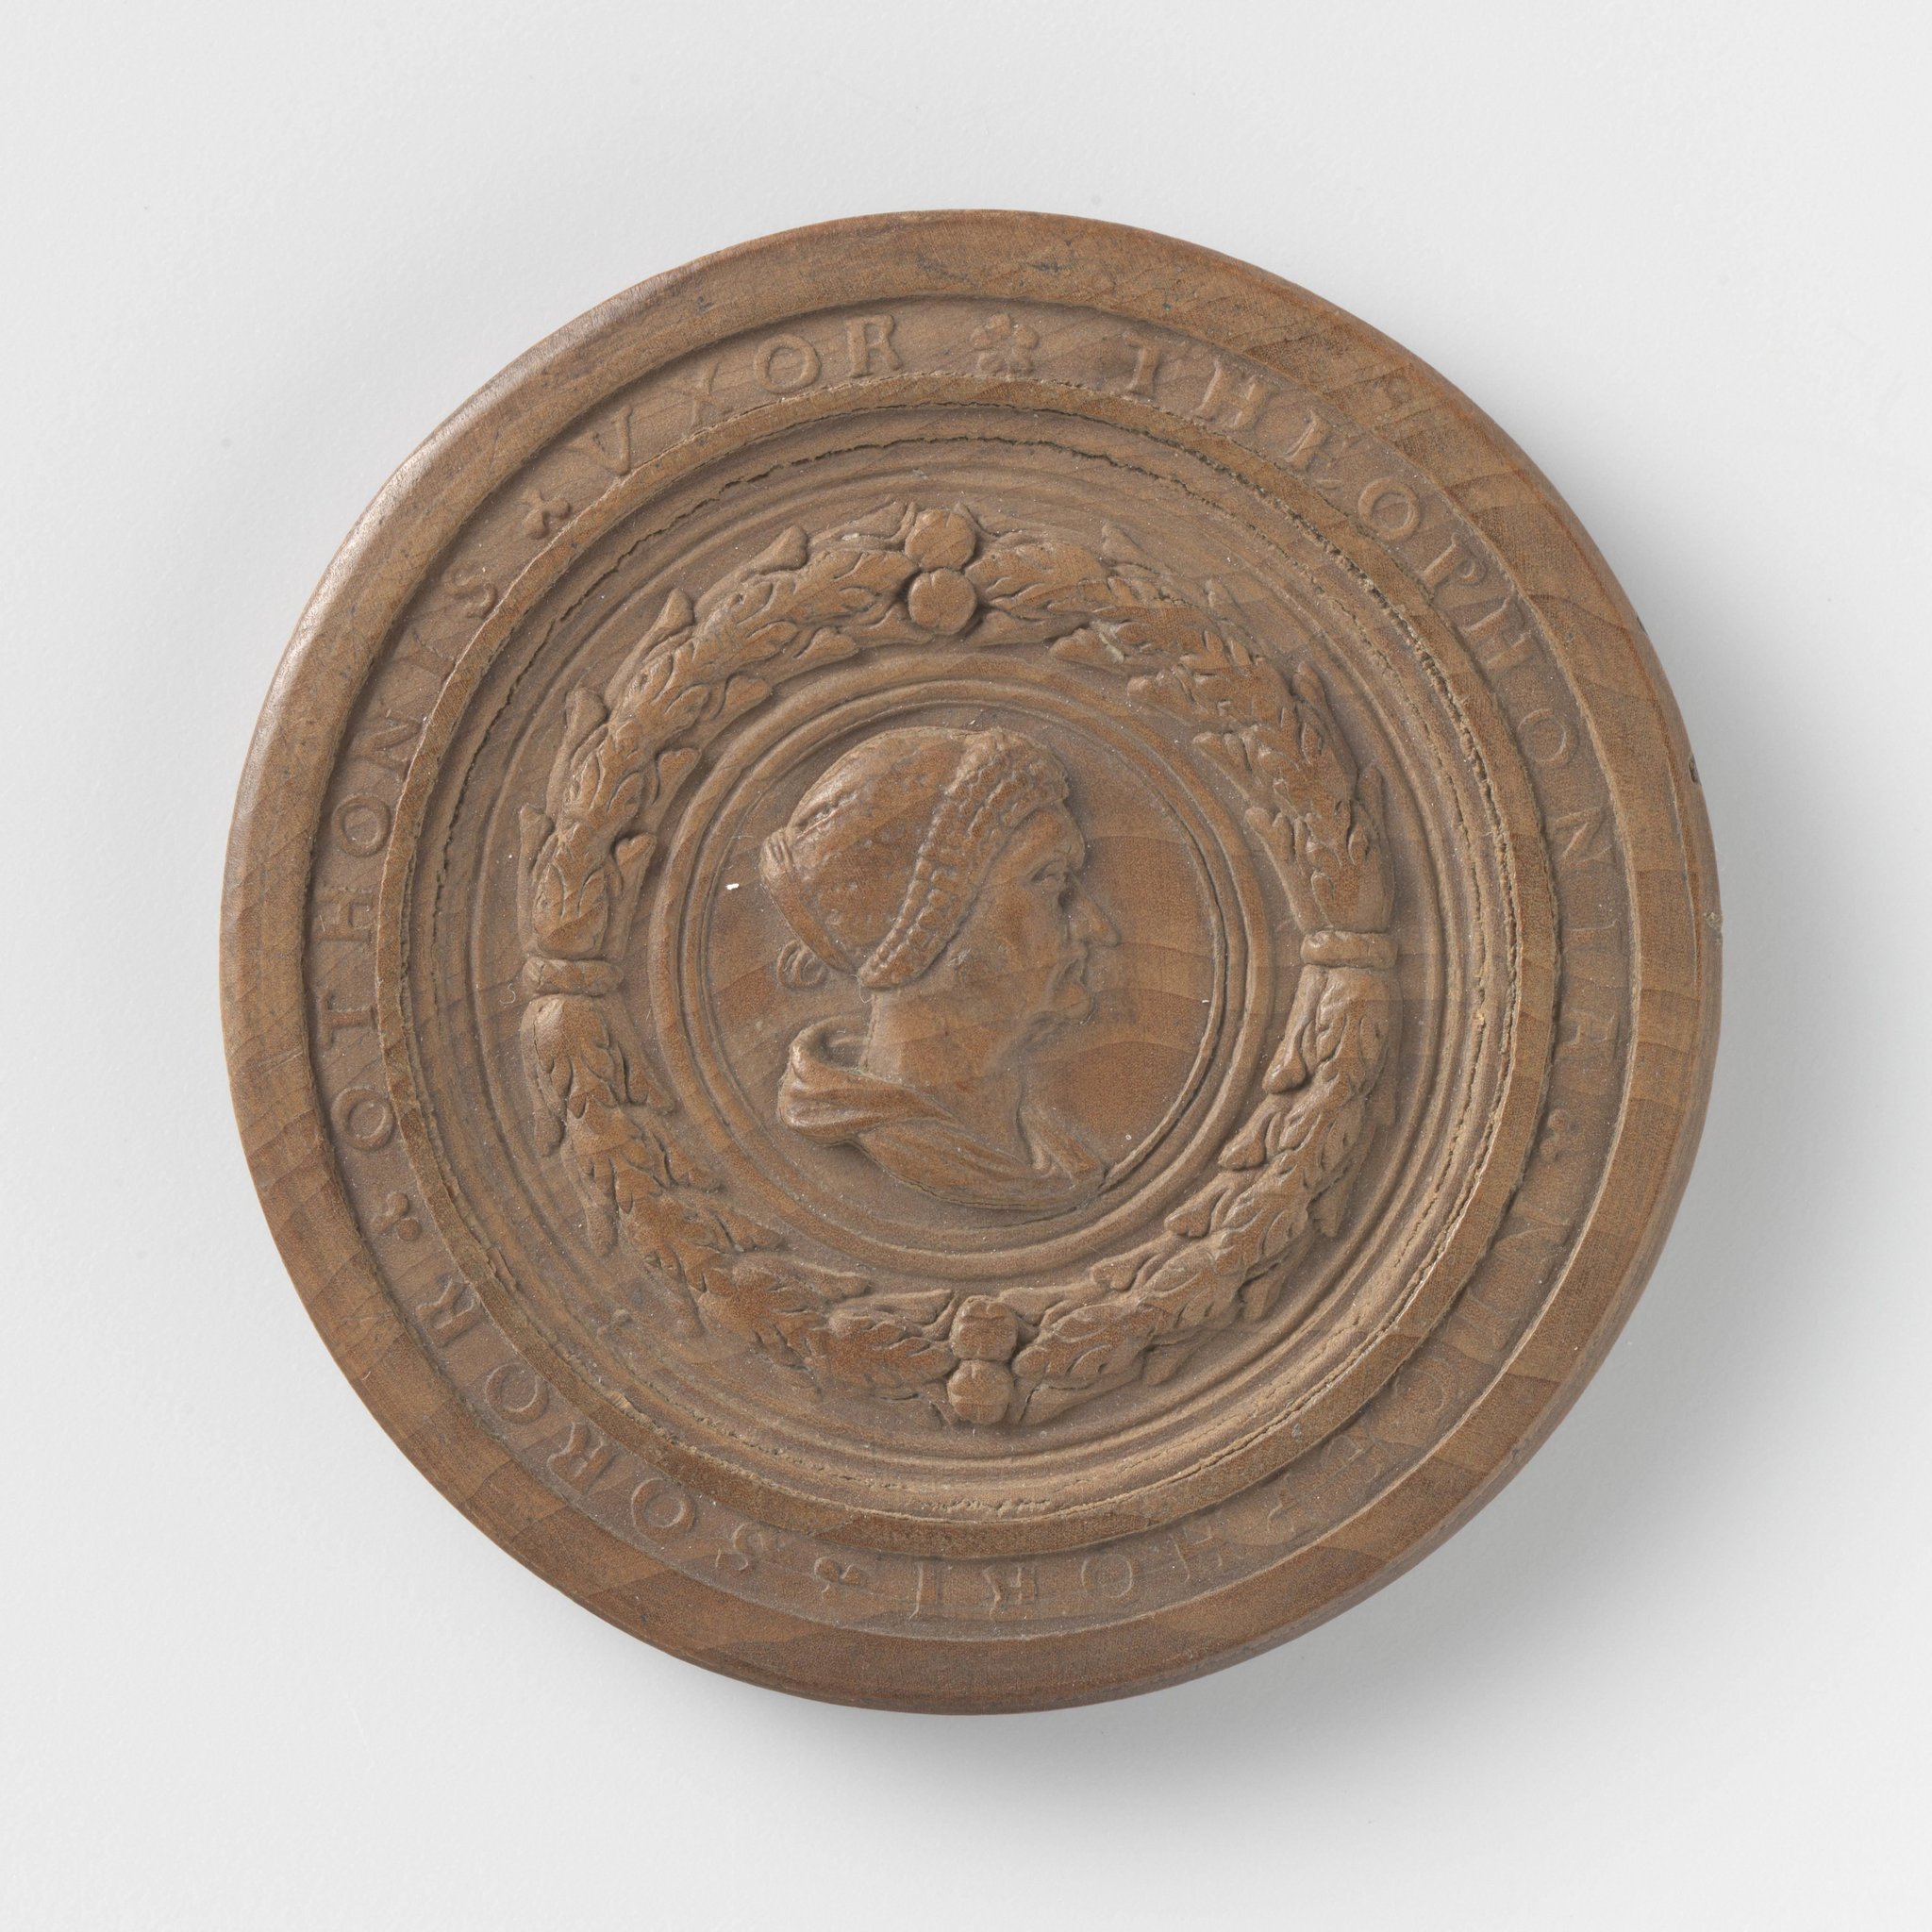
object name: checker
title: Helft van damschijf met portret: Theophano, vrouw van Otto II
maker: Anonymous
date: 1550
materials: wood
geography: nuremberg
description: THEOPHONIA. NICEPHORI. SOROR.OTHONIS.VXOR. Theophano, vanaf 972 gehowd met Otto II)